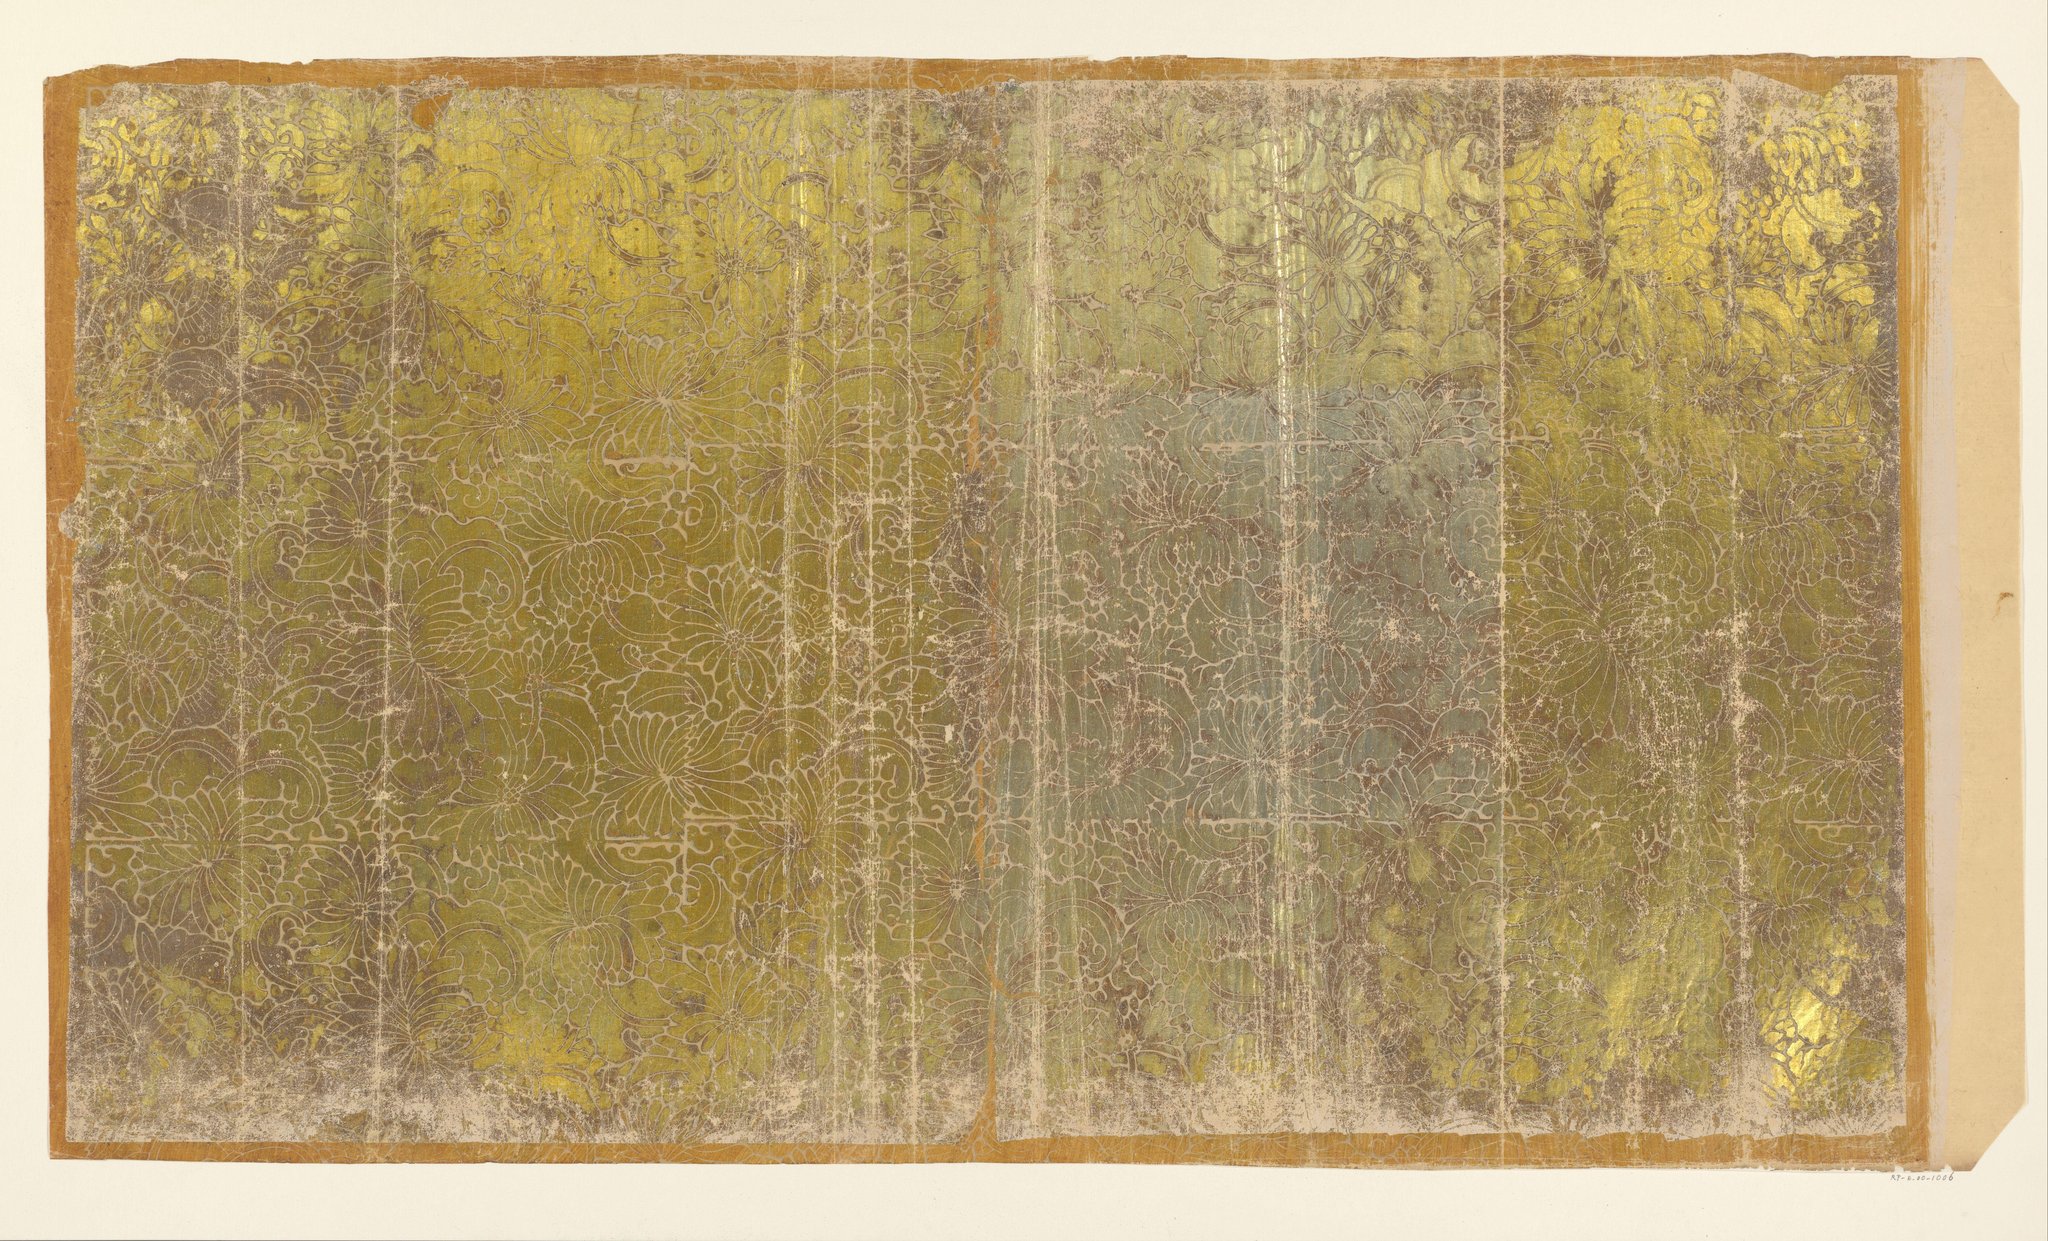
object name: decorated paper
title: Blad met aaneengesloten bladvullend patroon van chrysanten (één van tien identieke bladen)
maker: Anonymous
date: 1850-1950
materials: paper, gold leaf, paint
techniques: printing block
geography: japan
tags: flowers: chrysanthemum, ornament derived from plant forms